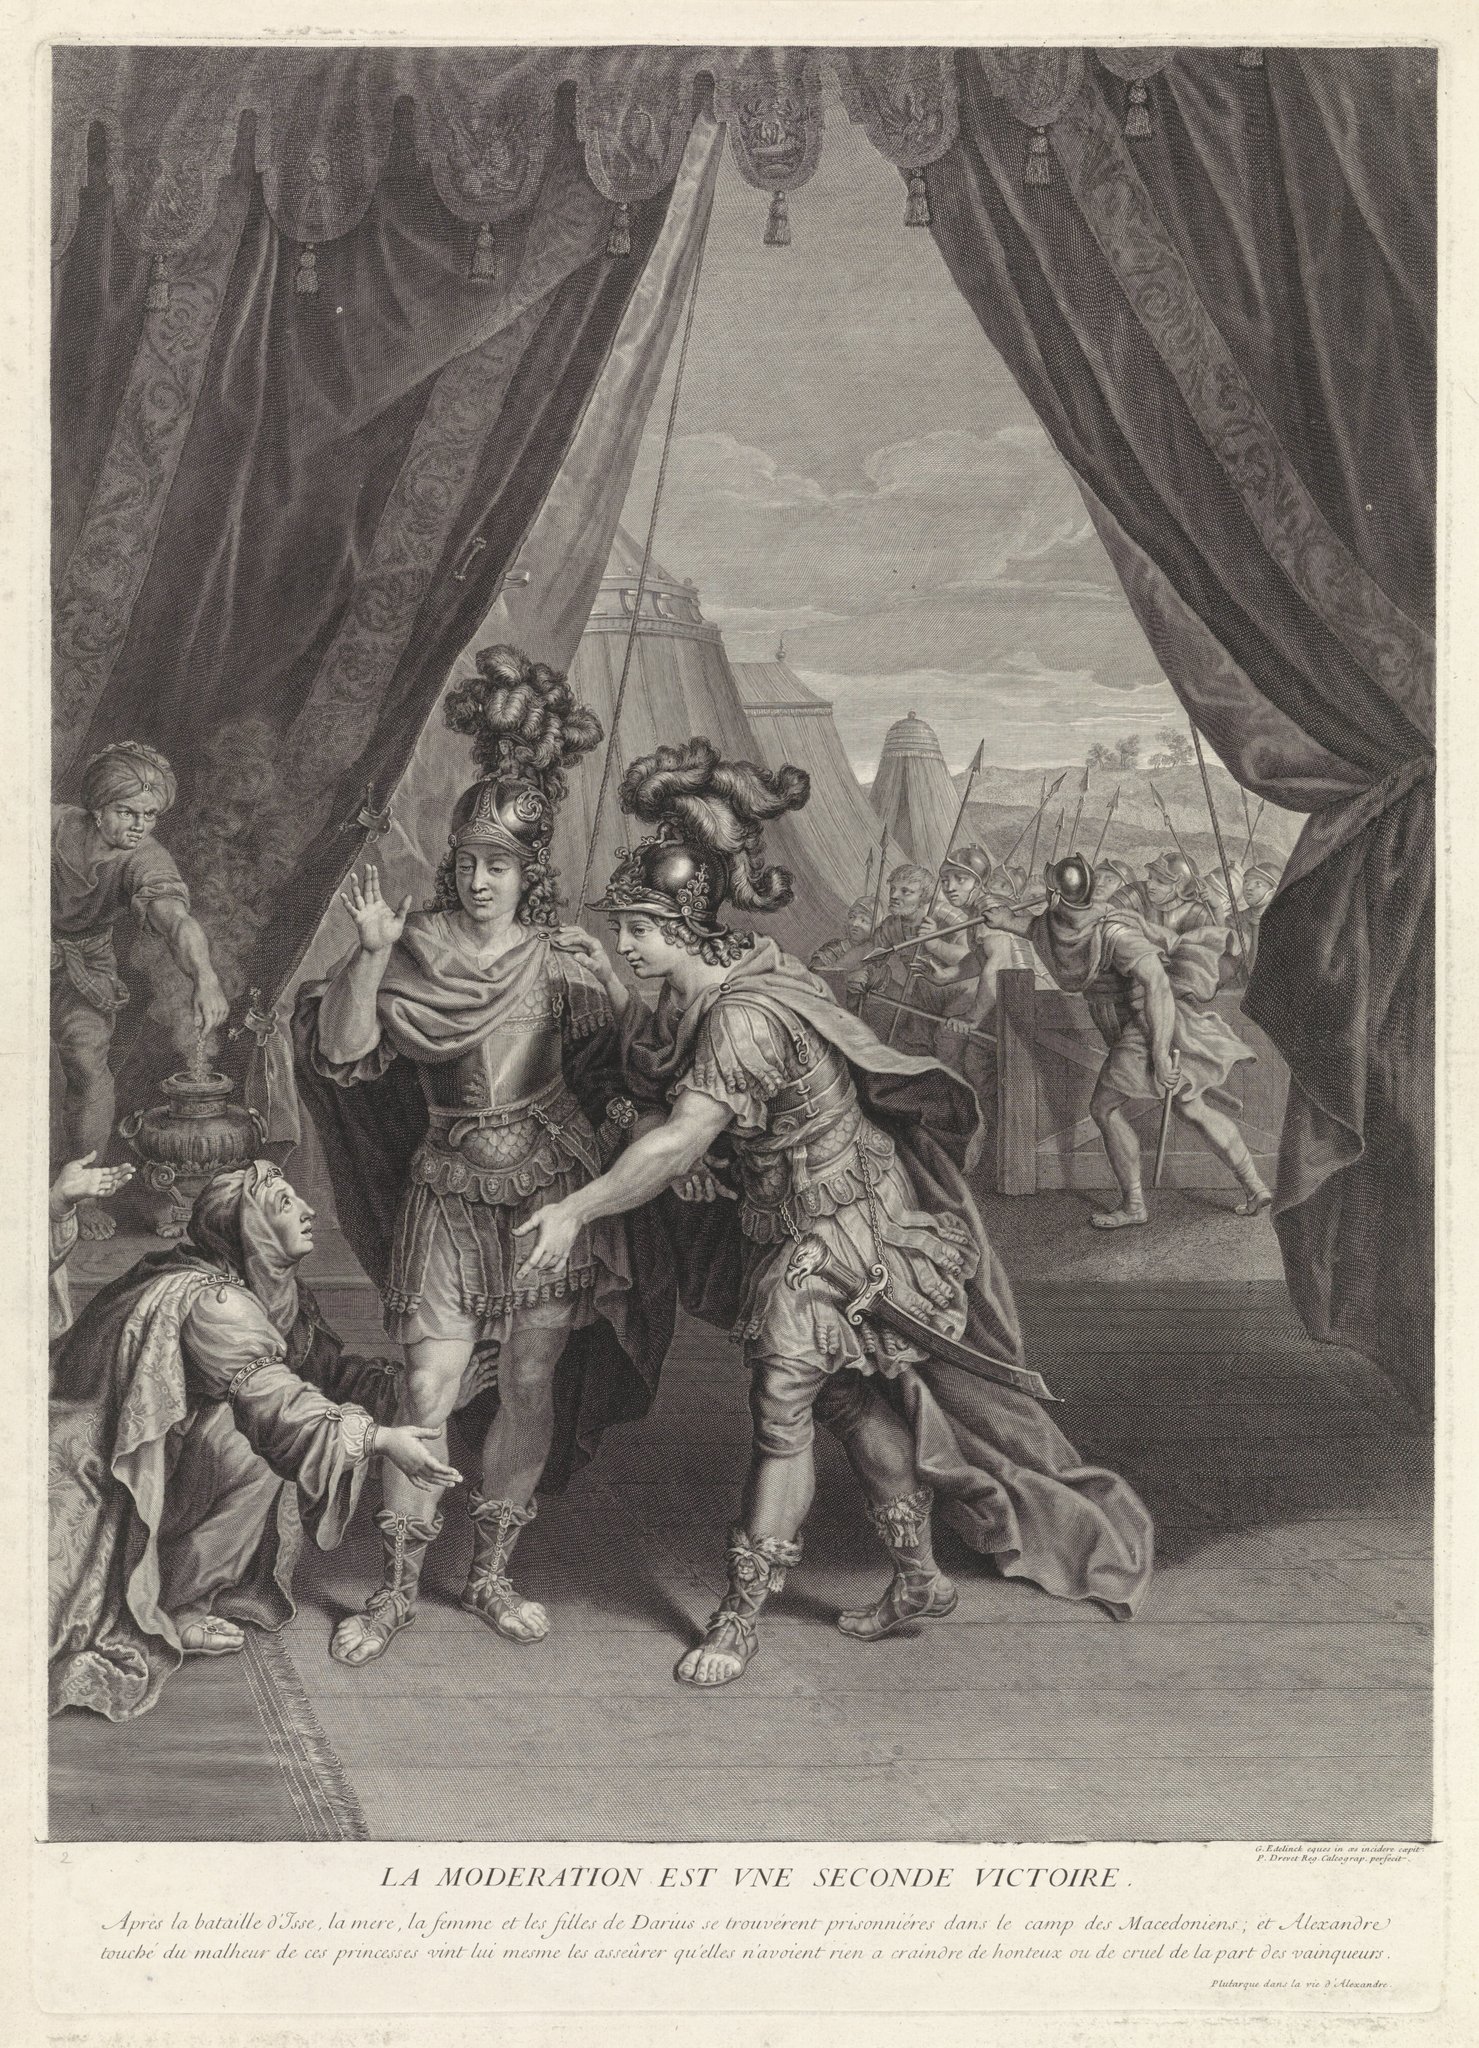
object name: print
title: Alexander de Grote bij de familie van Darius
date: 1666-1707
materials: paper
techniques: engraving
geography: paris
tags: darius' family kneels before alexander, who requests sisigambis, darius' mother, to rise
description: Rechter deel van een prent met het bezoek van Alexander de Grote en Hephaestion aan de gevangen genomen familie van de Perzische koning Darius III na de slag bij Issos. De moeder van Darius knielt per abuis voor Hephaestion, maar Alexander vergeeft haar en gebaart haar op te staan. Onder de voostelling drie regels Frans.